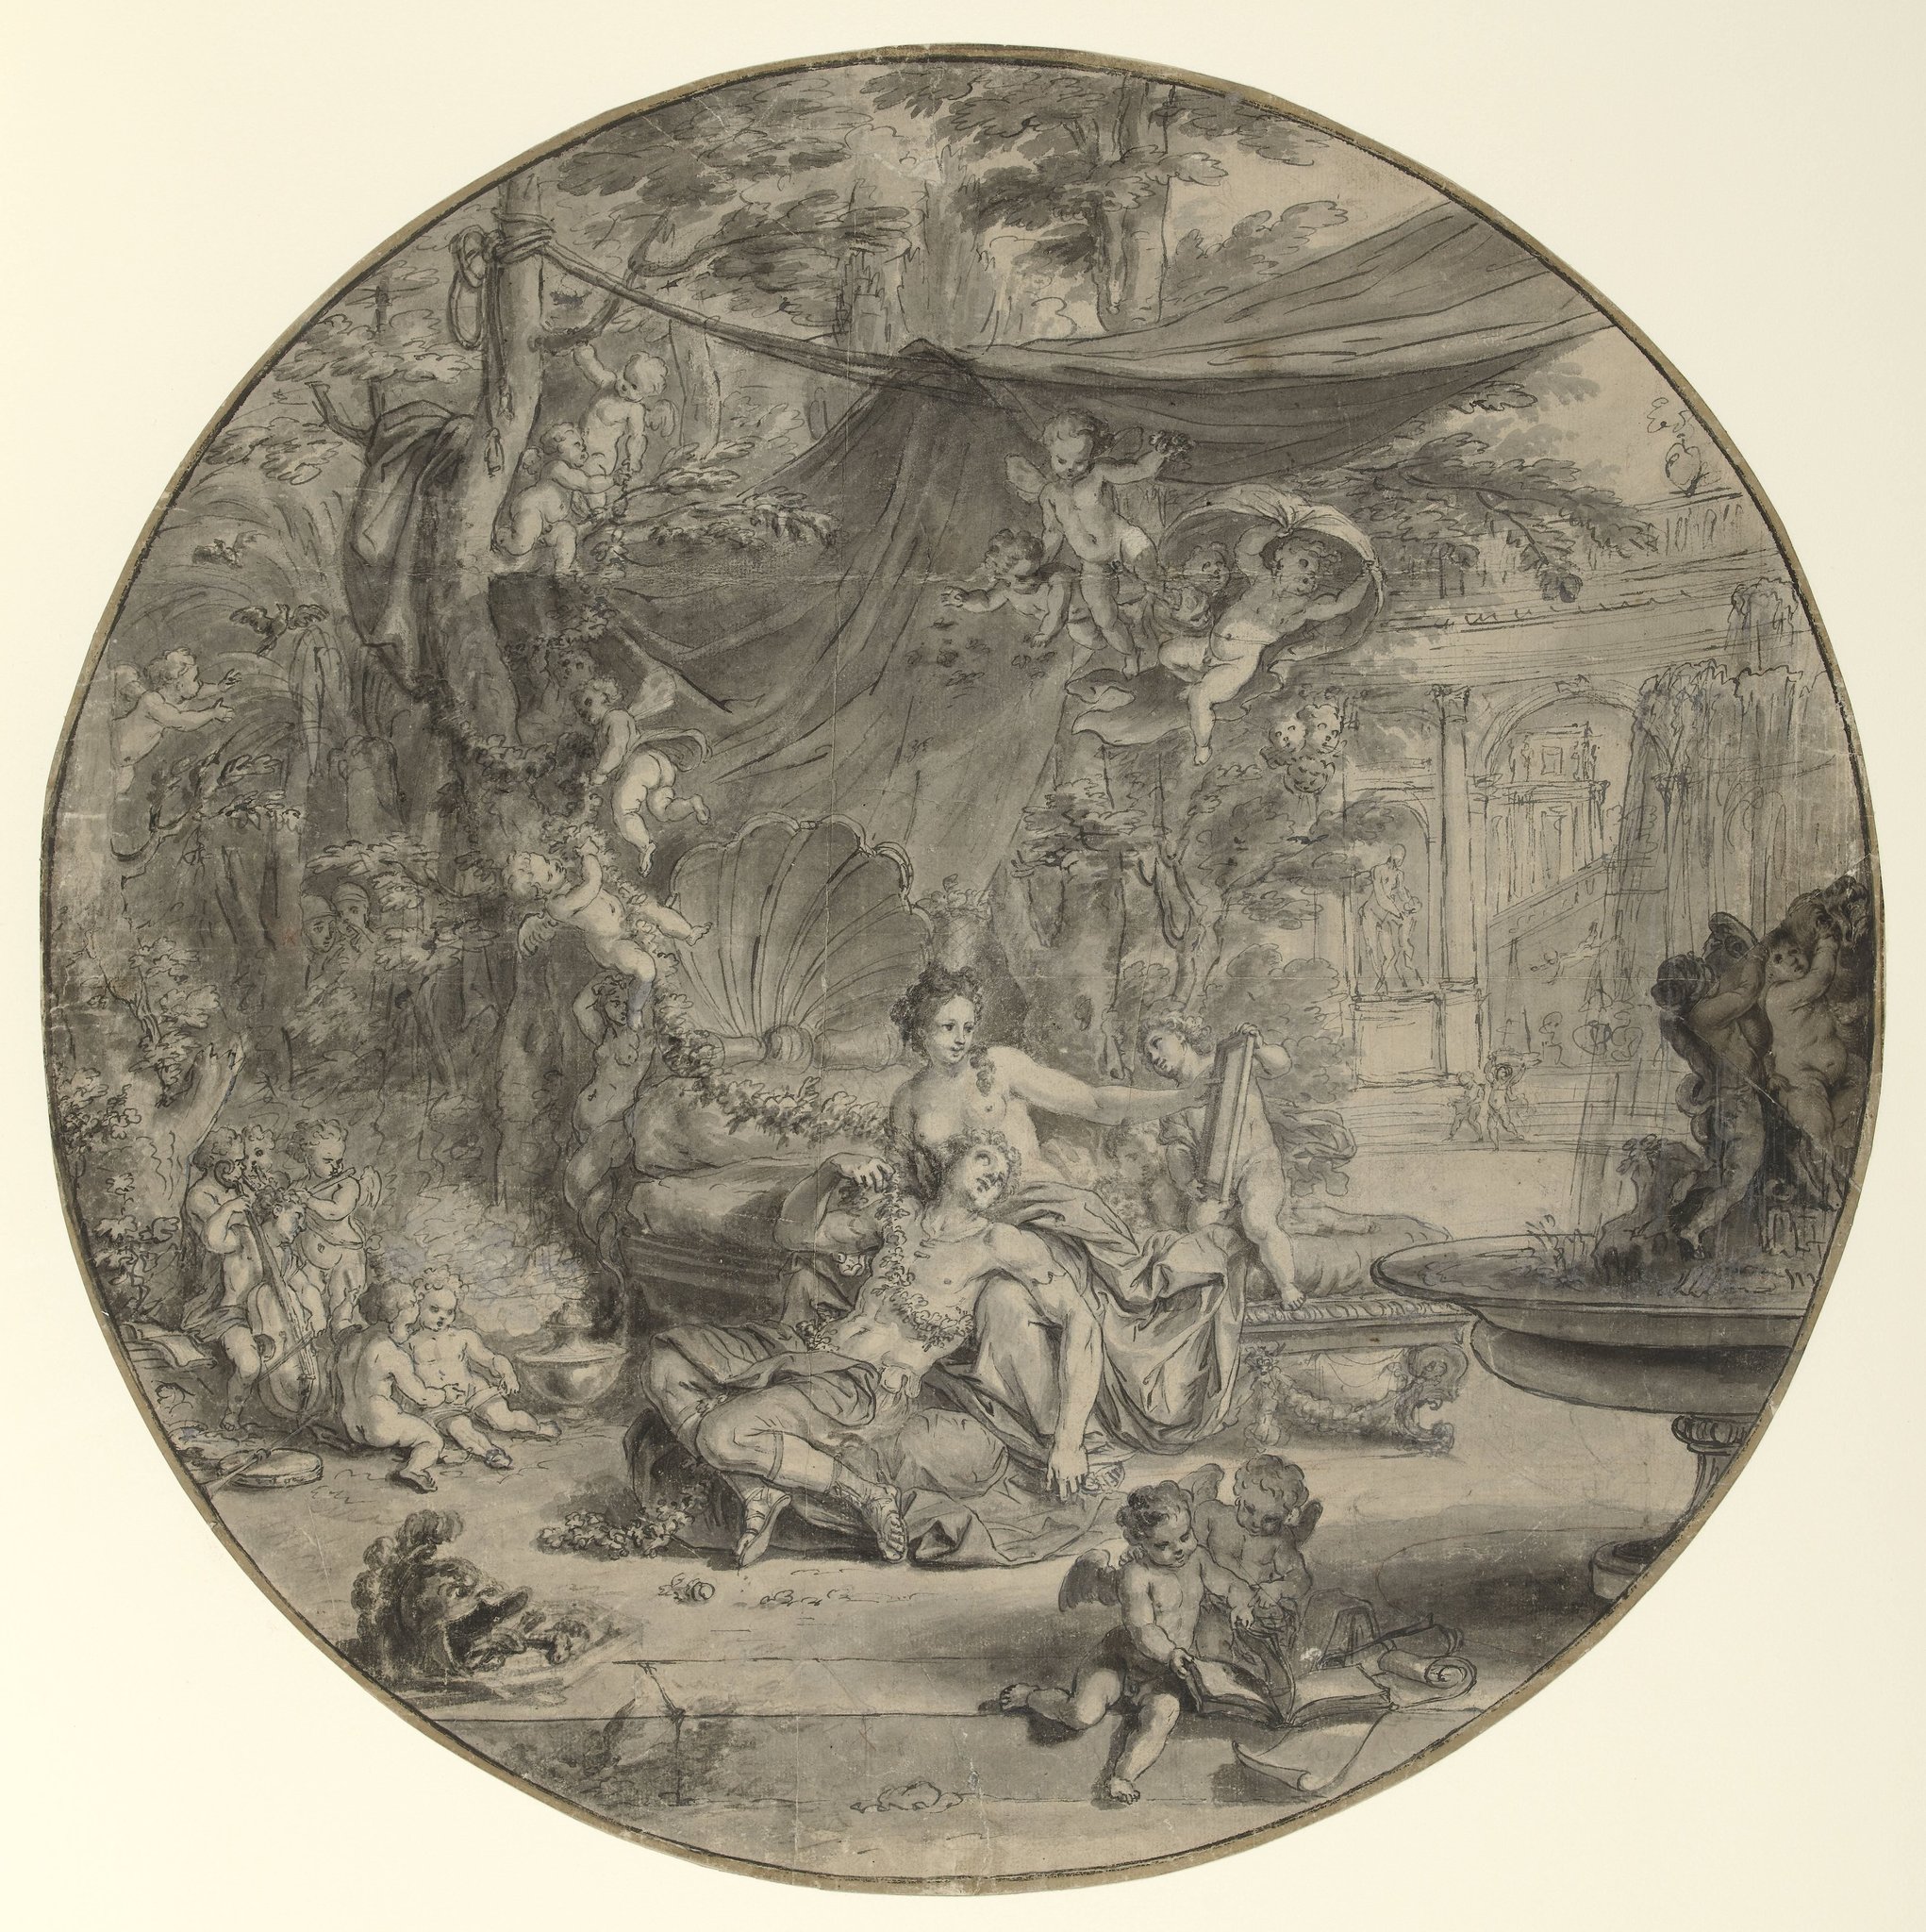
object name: design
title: Rinaldo en Armida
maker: bernard picart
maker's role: draughtsman, print maker, publisher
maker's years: 1673-1733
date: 1683-1733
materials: paint, ink, paper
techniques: brush, pen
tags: sitting figure (+ two persons), armida